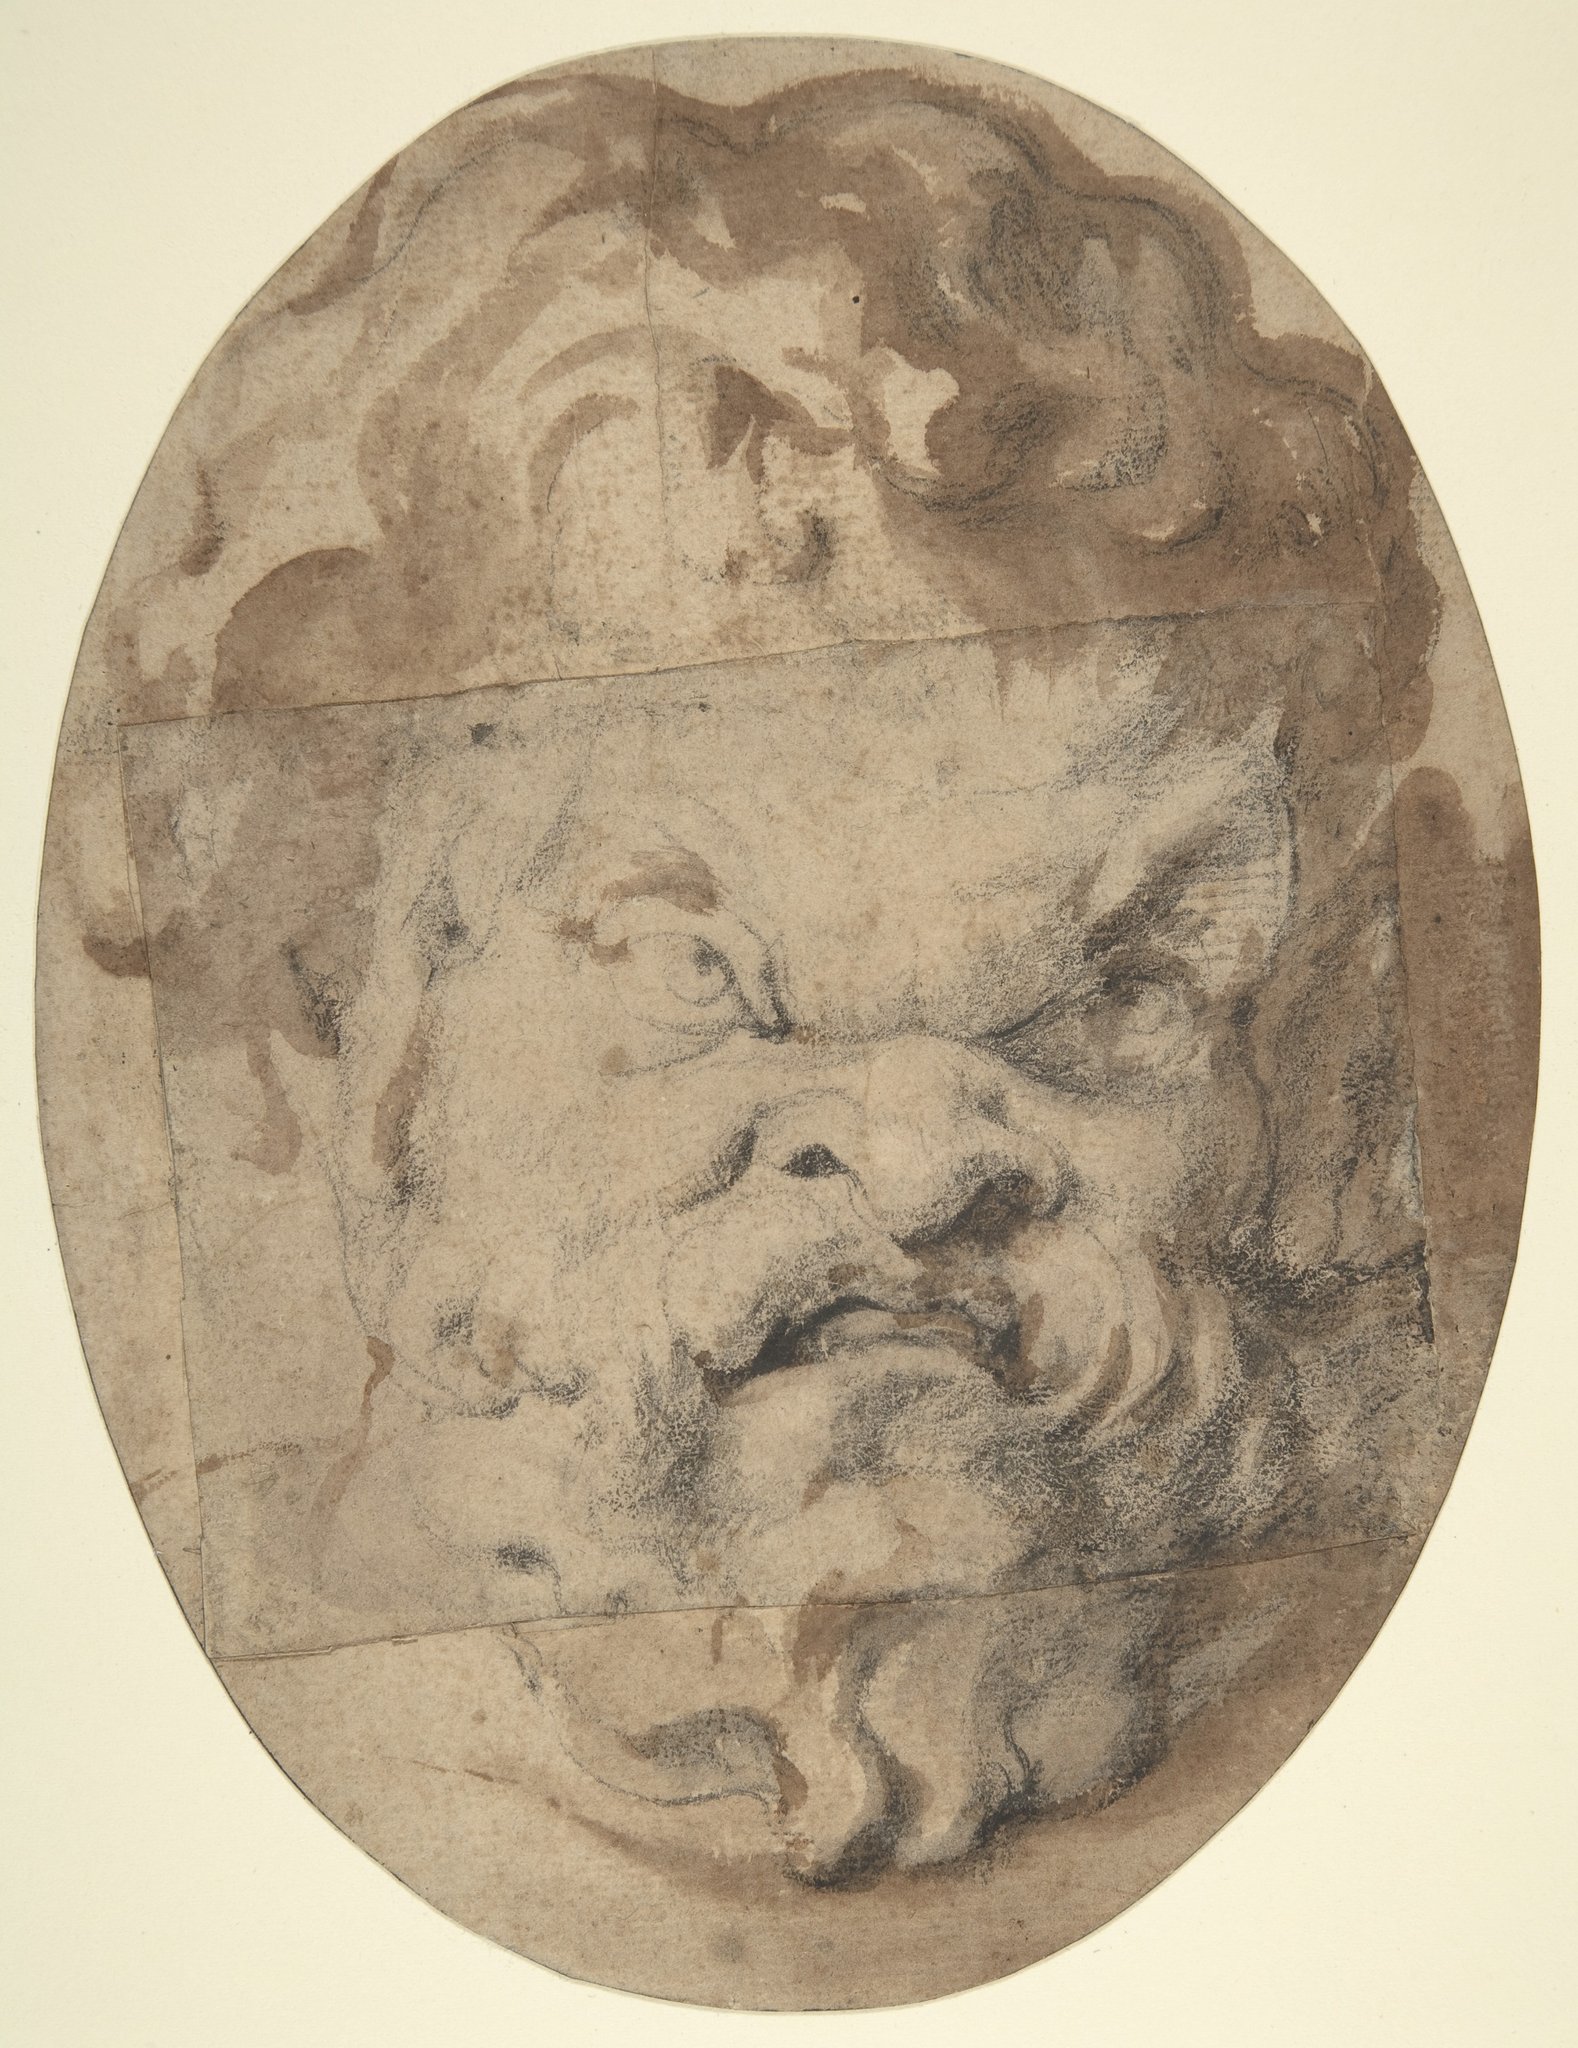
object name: drawing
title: Head of a Satyr (Silenus)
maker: peter paul rubens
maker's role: artist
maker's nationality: flemish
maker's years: 1577-1640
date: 1620-1630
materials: chalk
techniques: brush, wash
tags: satyrs